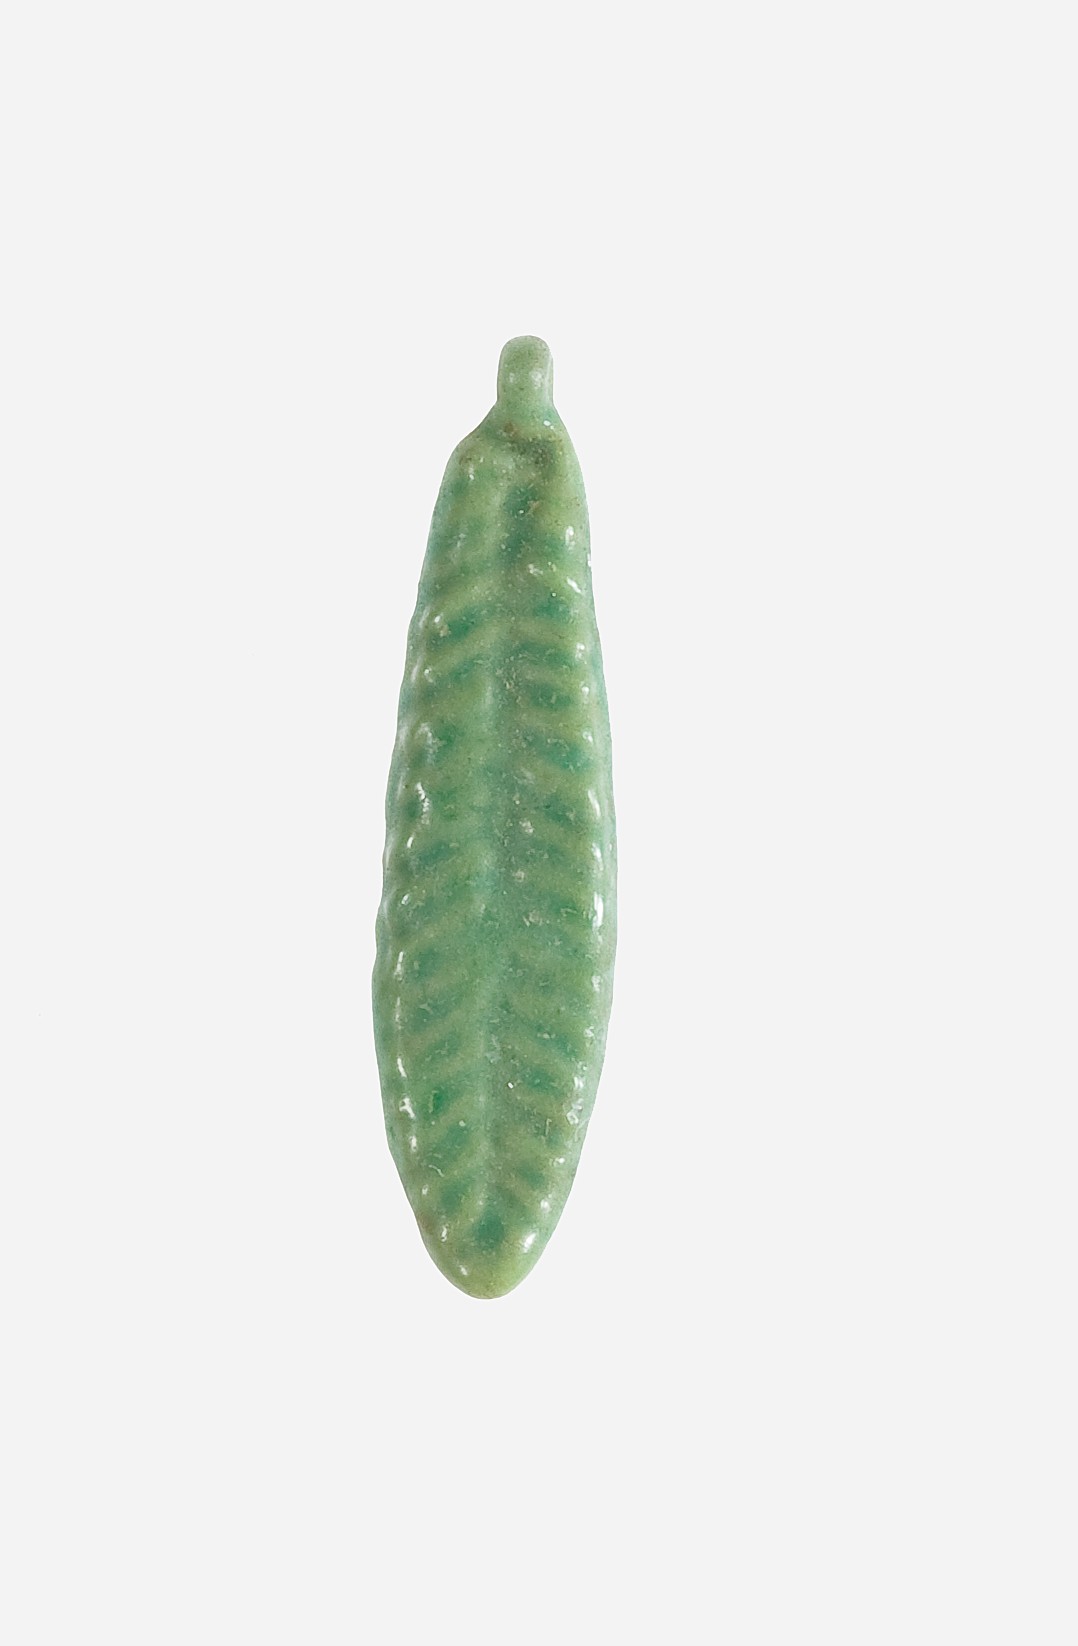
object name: pendant, leaf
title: Leaf Pendant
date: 1390-1352 BCE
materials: faience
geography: egypt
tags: leaves